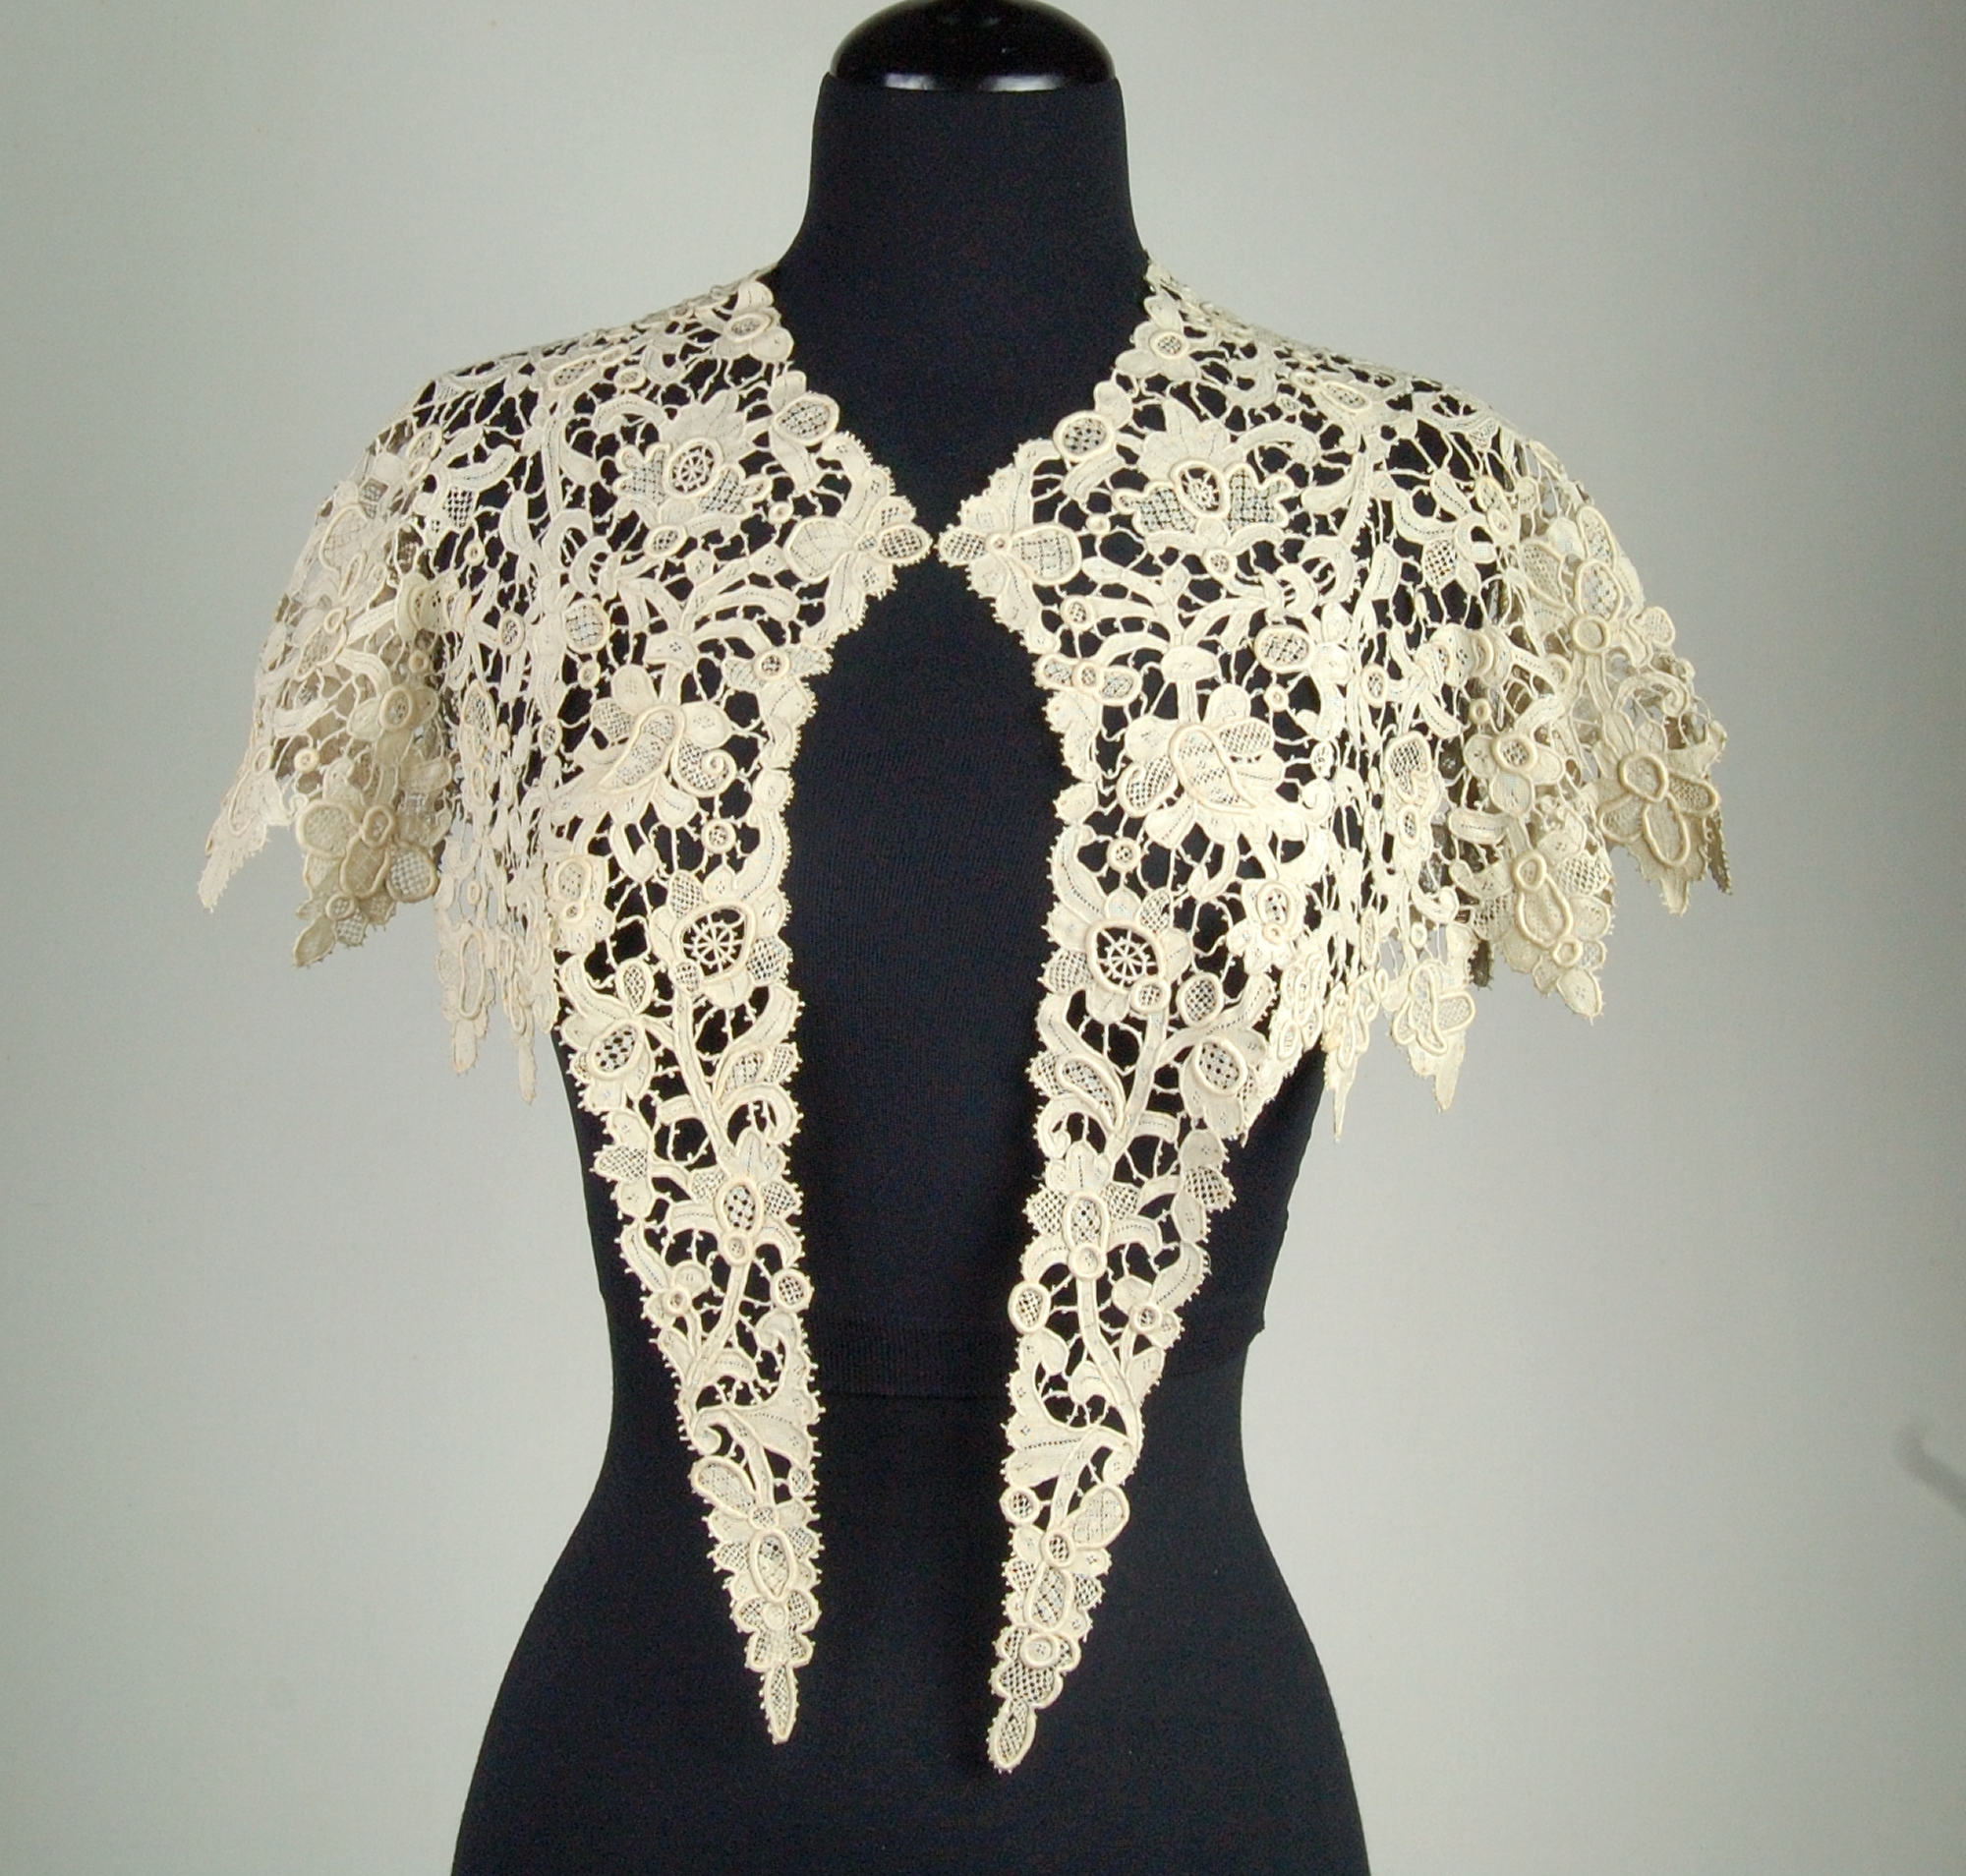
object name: pelerine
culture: italian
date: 1890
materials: linen